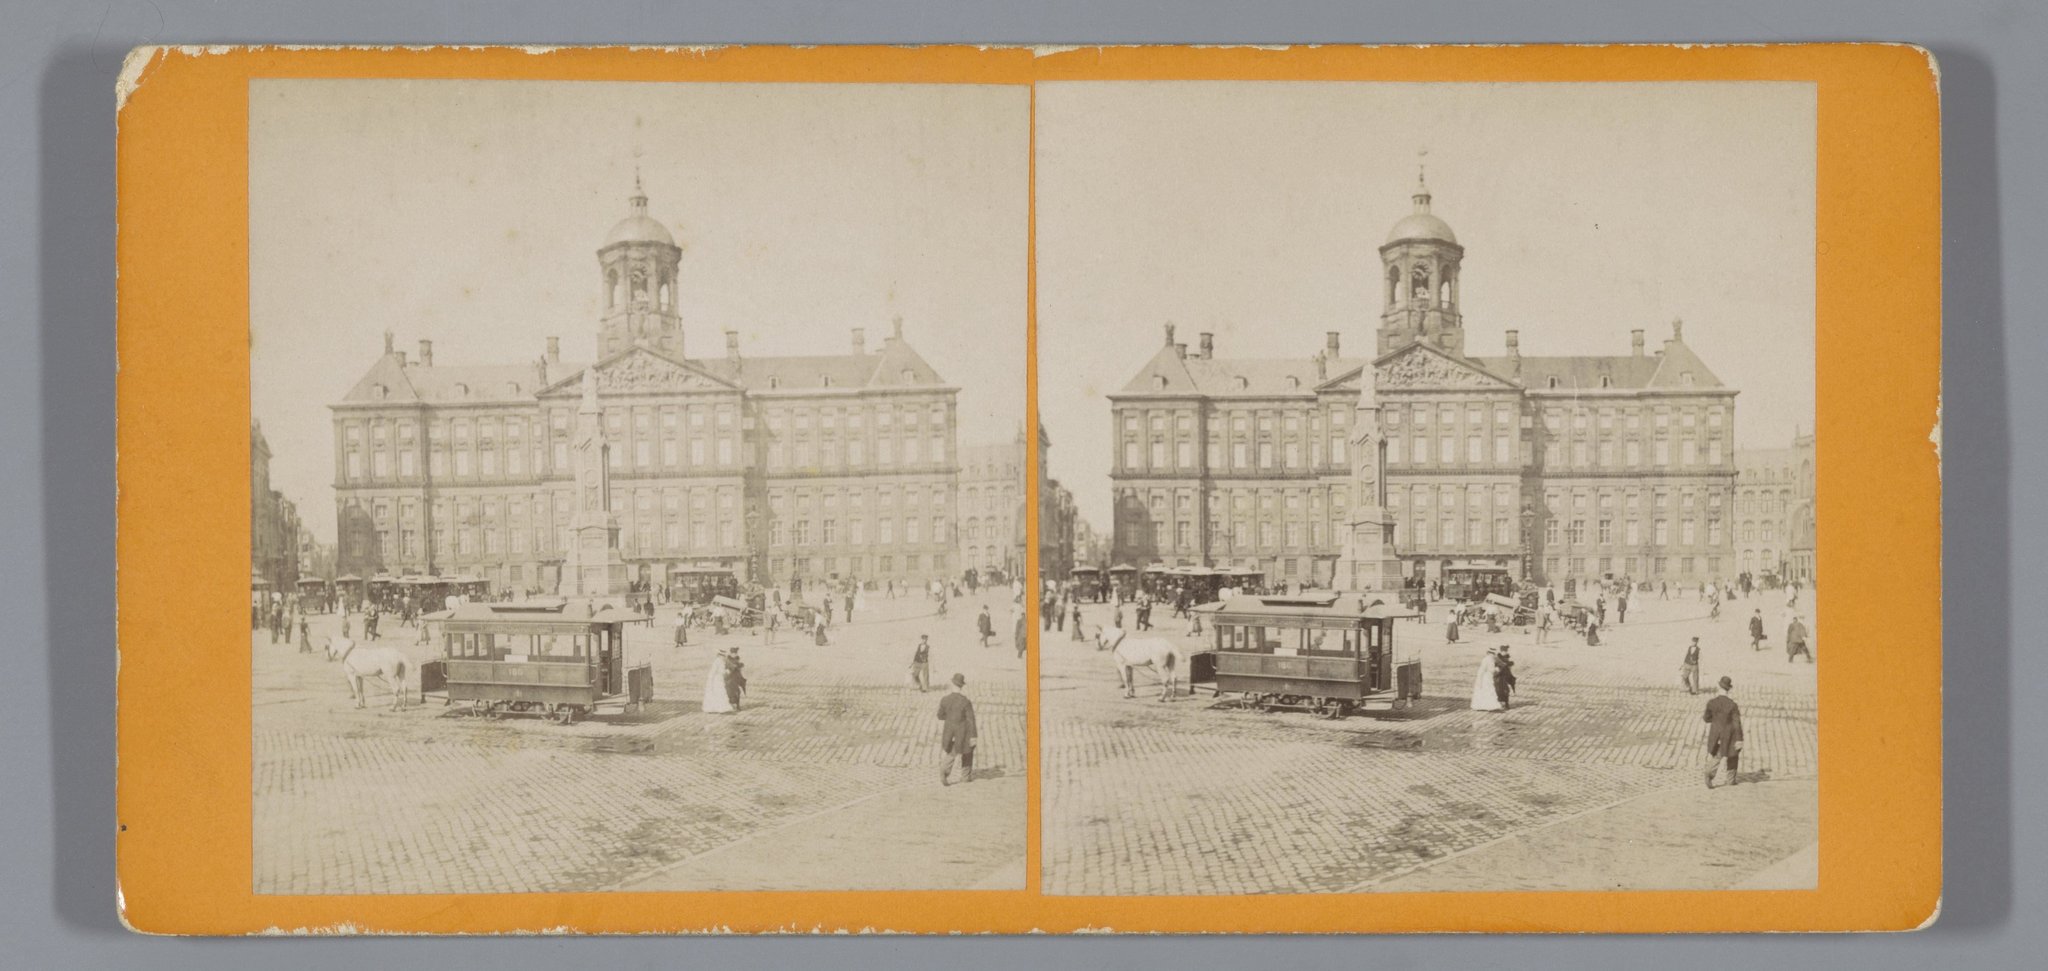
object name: stereograph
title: Koninklijk Paleis op de Dam, Amsterdam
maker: Anonymous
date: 1877-1900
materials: cardboard, paper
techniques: albumen print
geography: amsterdam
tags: square, place, circus, etc., palace, royal palace of amsterdam